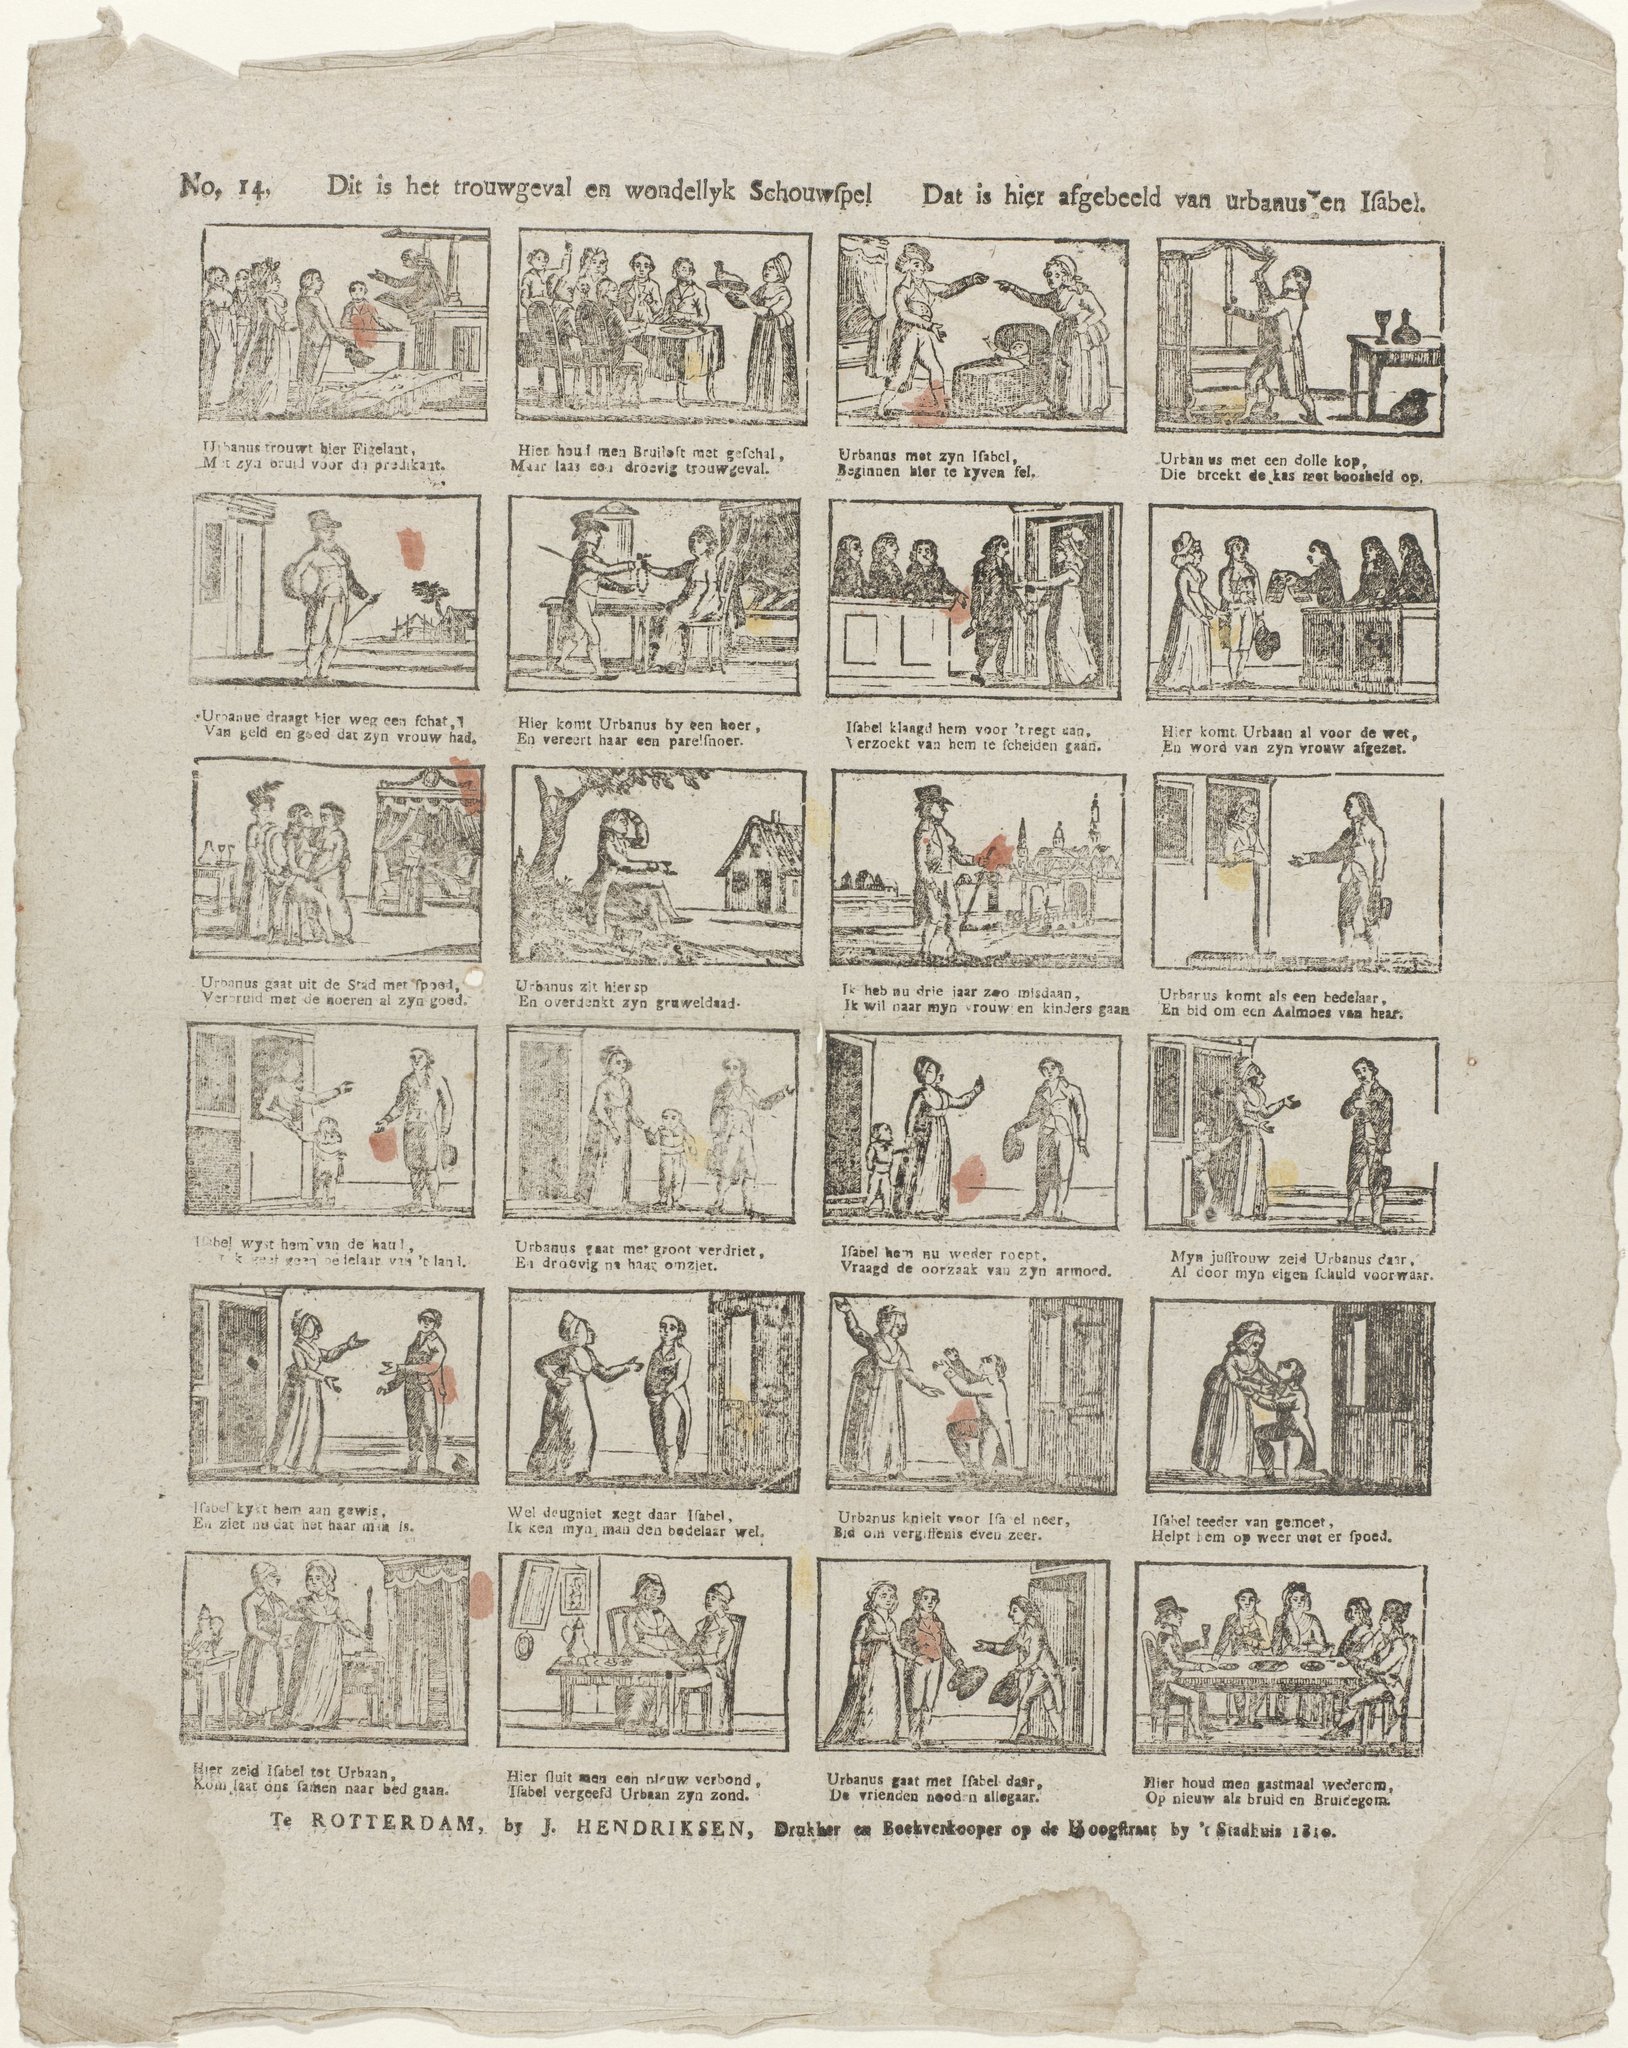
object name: popular print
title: Dit is het trouwgeval en wondellyk schouwspel / Dat is hier afgebeeld van Urbanus en Isabel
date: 1810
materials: paper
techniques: colour, letterpress printing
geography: rotterdam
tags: divorce, beggar, man and wife quarrelling, 'marriage à la mode'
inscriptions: date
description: Blad met 24 voorstellingen uit het leven van Urbanus en Isabel. Ze trouwen, maken ruzie, gaan scheiden, en Urbanus wordt een bedelaar. Onder elke voorstelling een tweeregelig vers. Genummerd linksboven: No, 14.